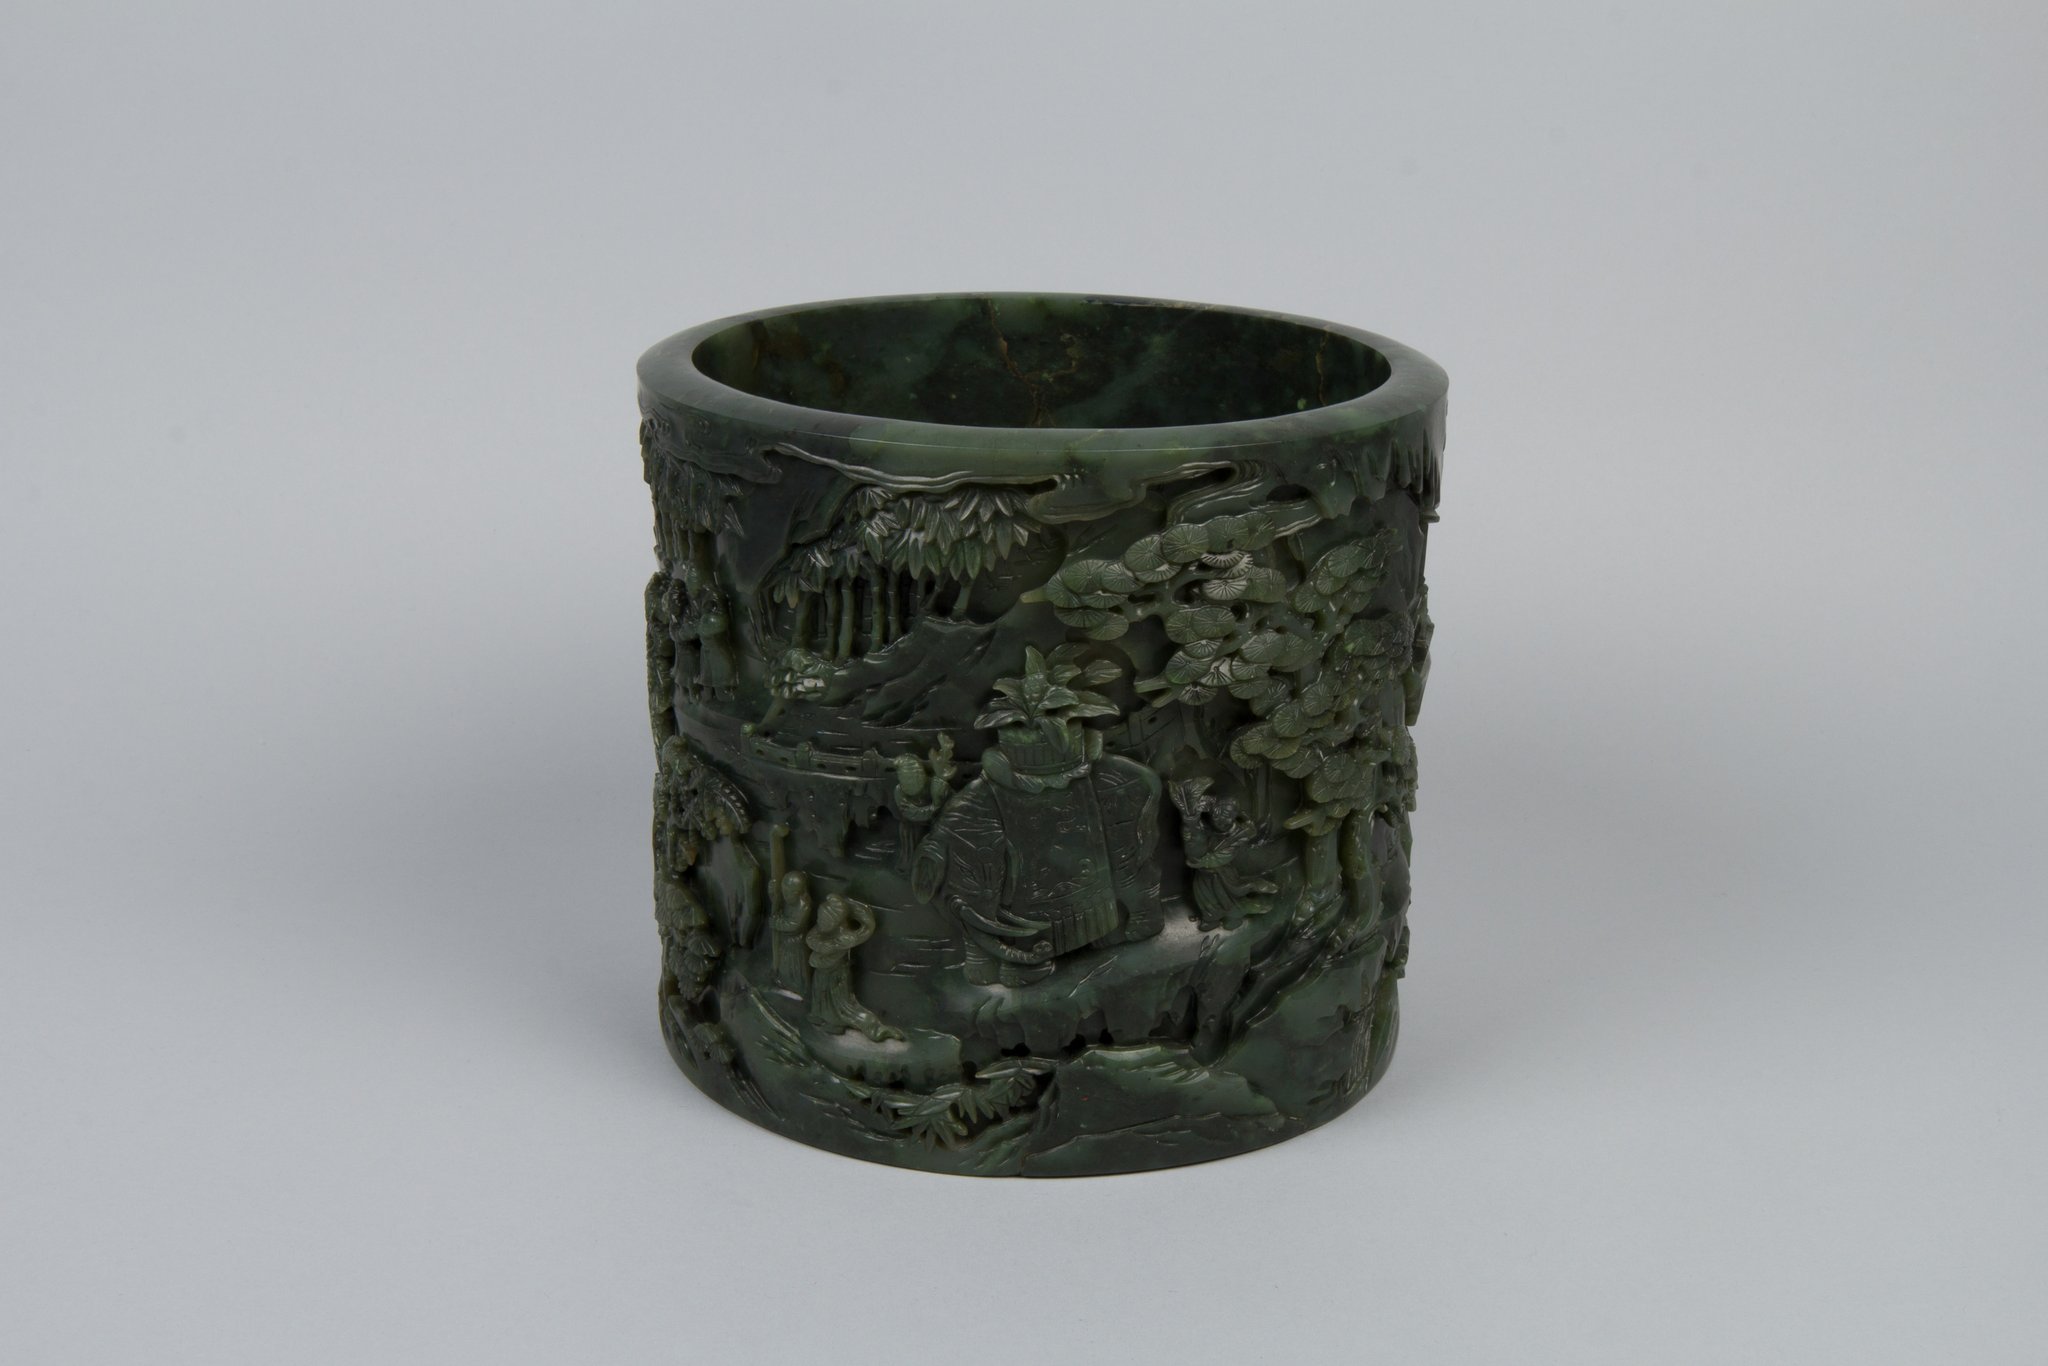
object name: brush holder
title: Brush holder with tribute scene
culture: chinese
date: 1701-1800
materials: jade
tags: human figures,elephants,mountains